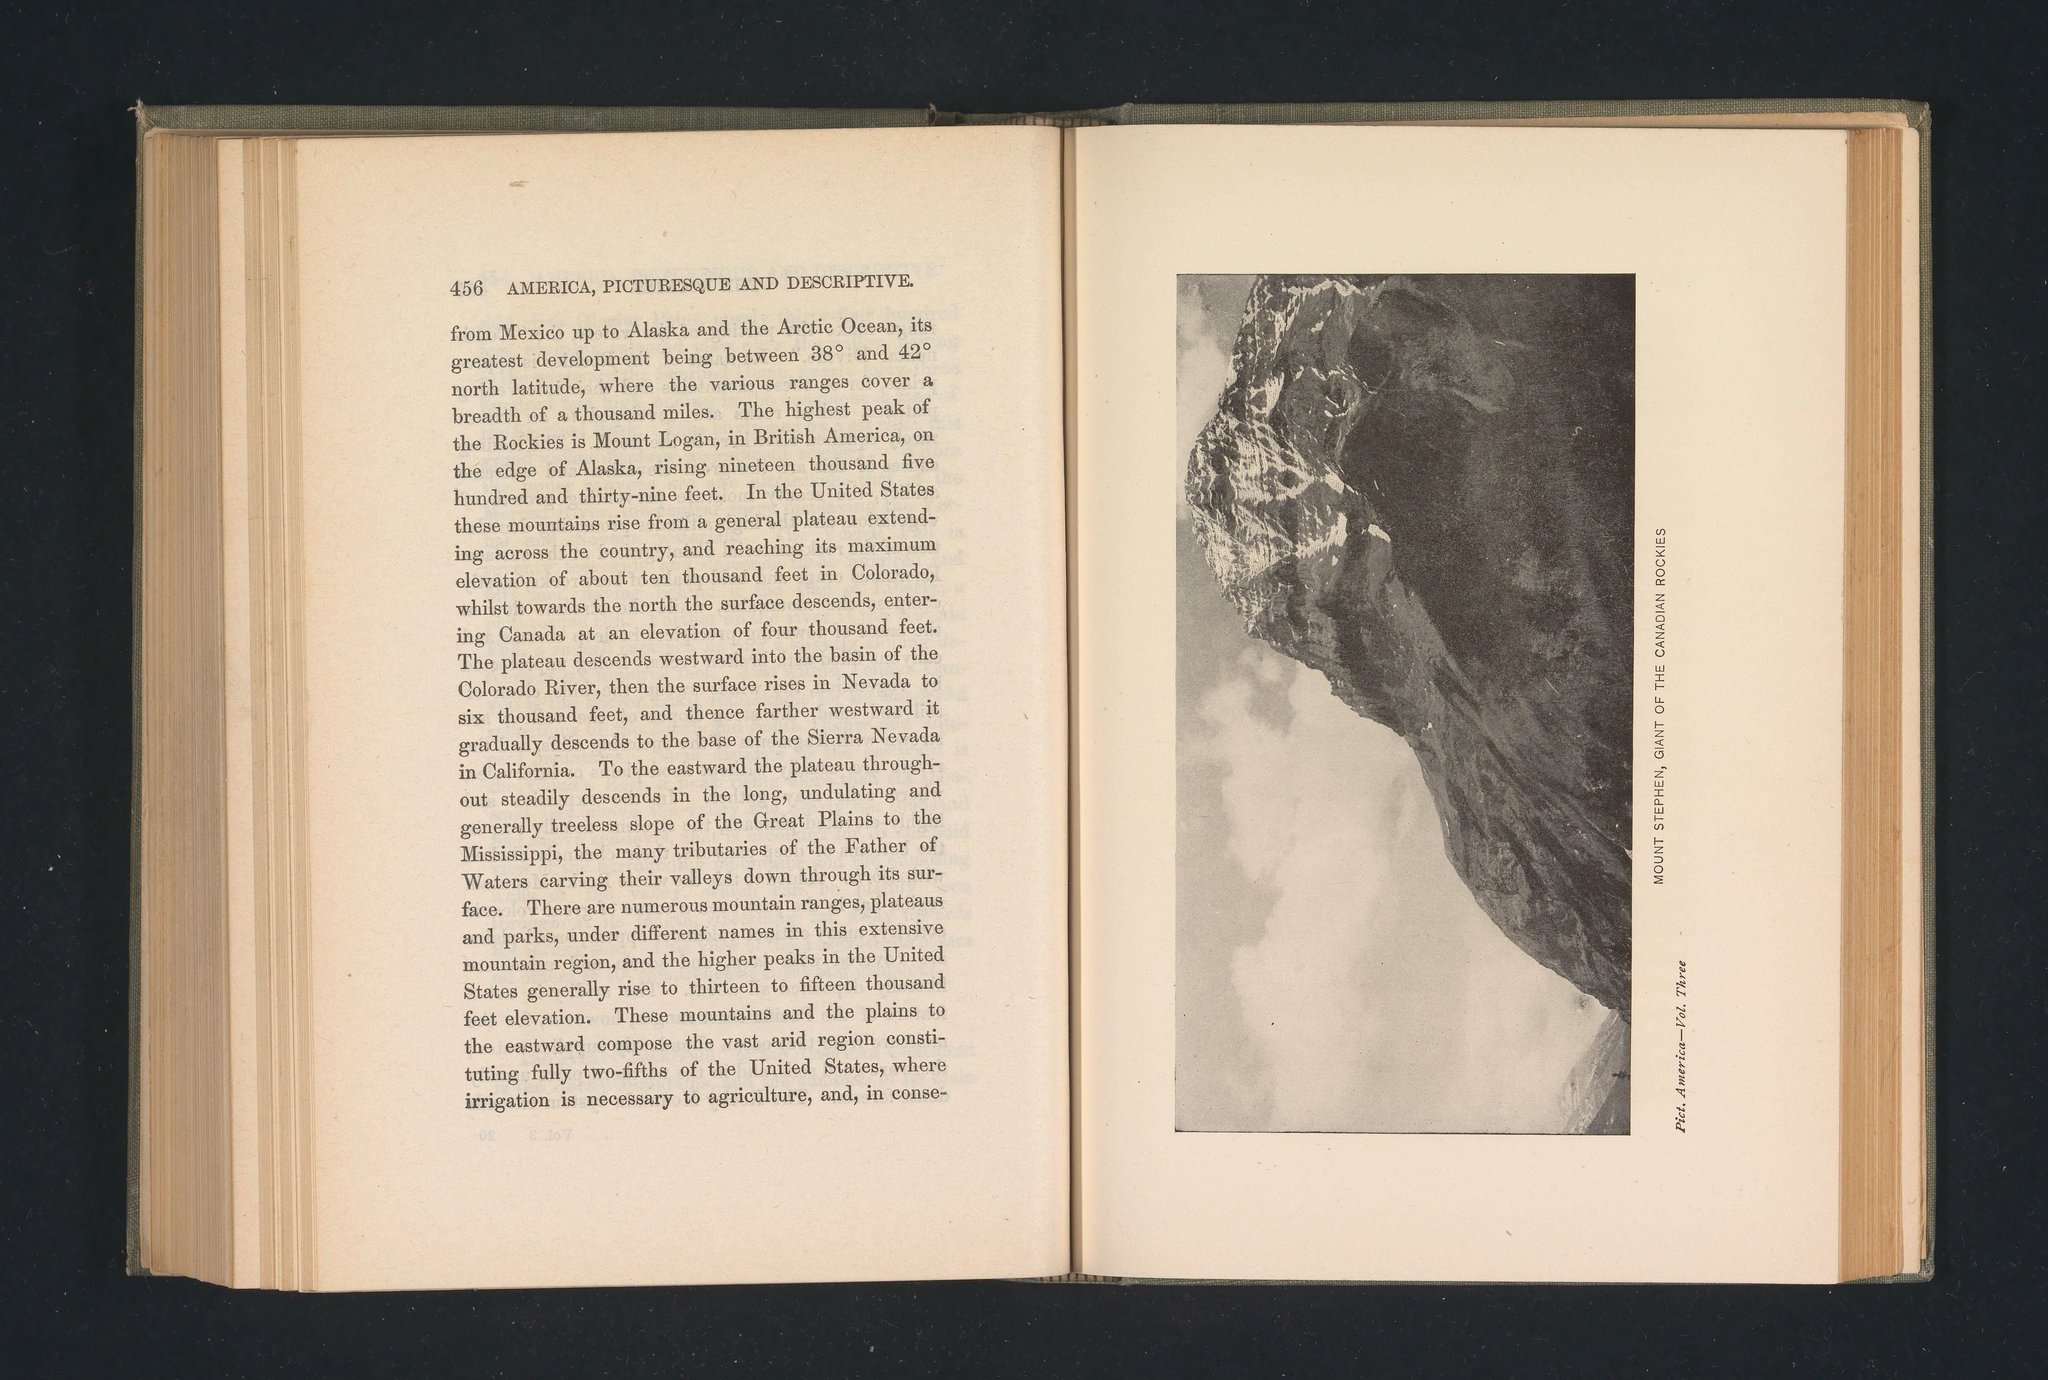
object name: photomechanical print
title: Mount Stephen, giant of the Canadian Rockies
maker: Anonymous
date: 1890-1900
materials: paper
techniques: autotype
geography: canada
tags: mountains